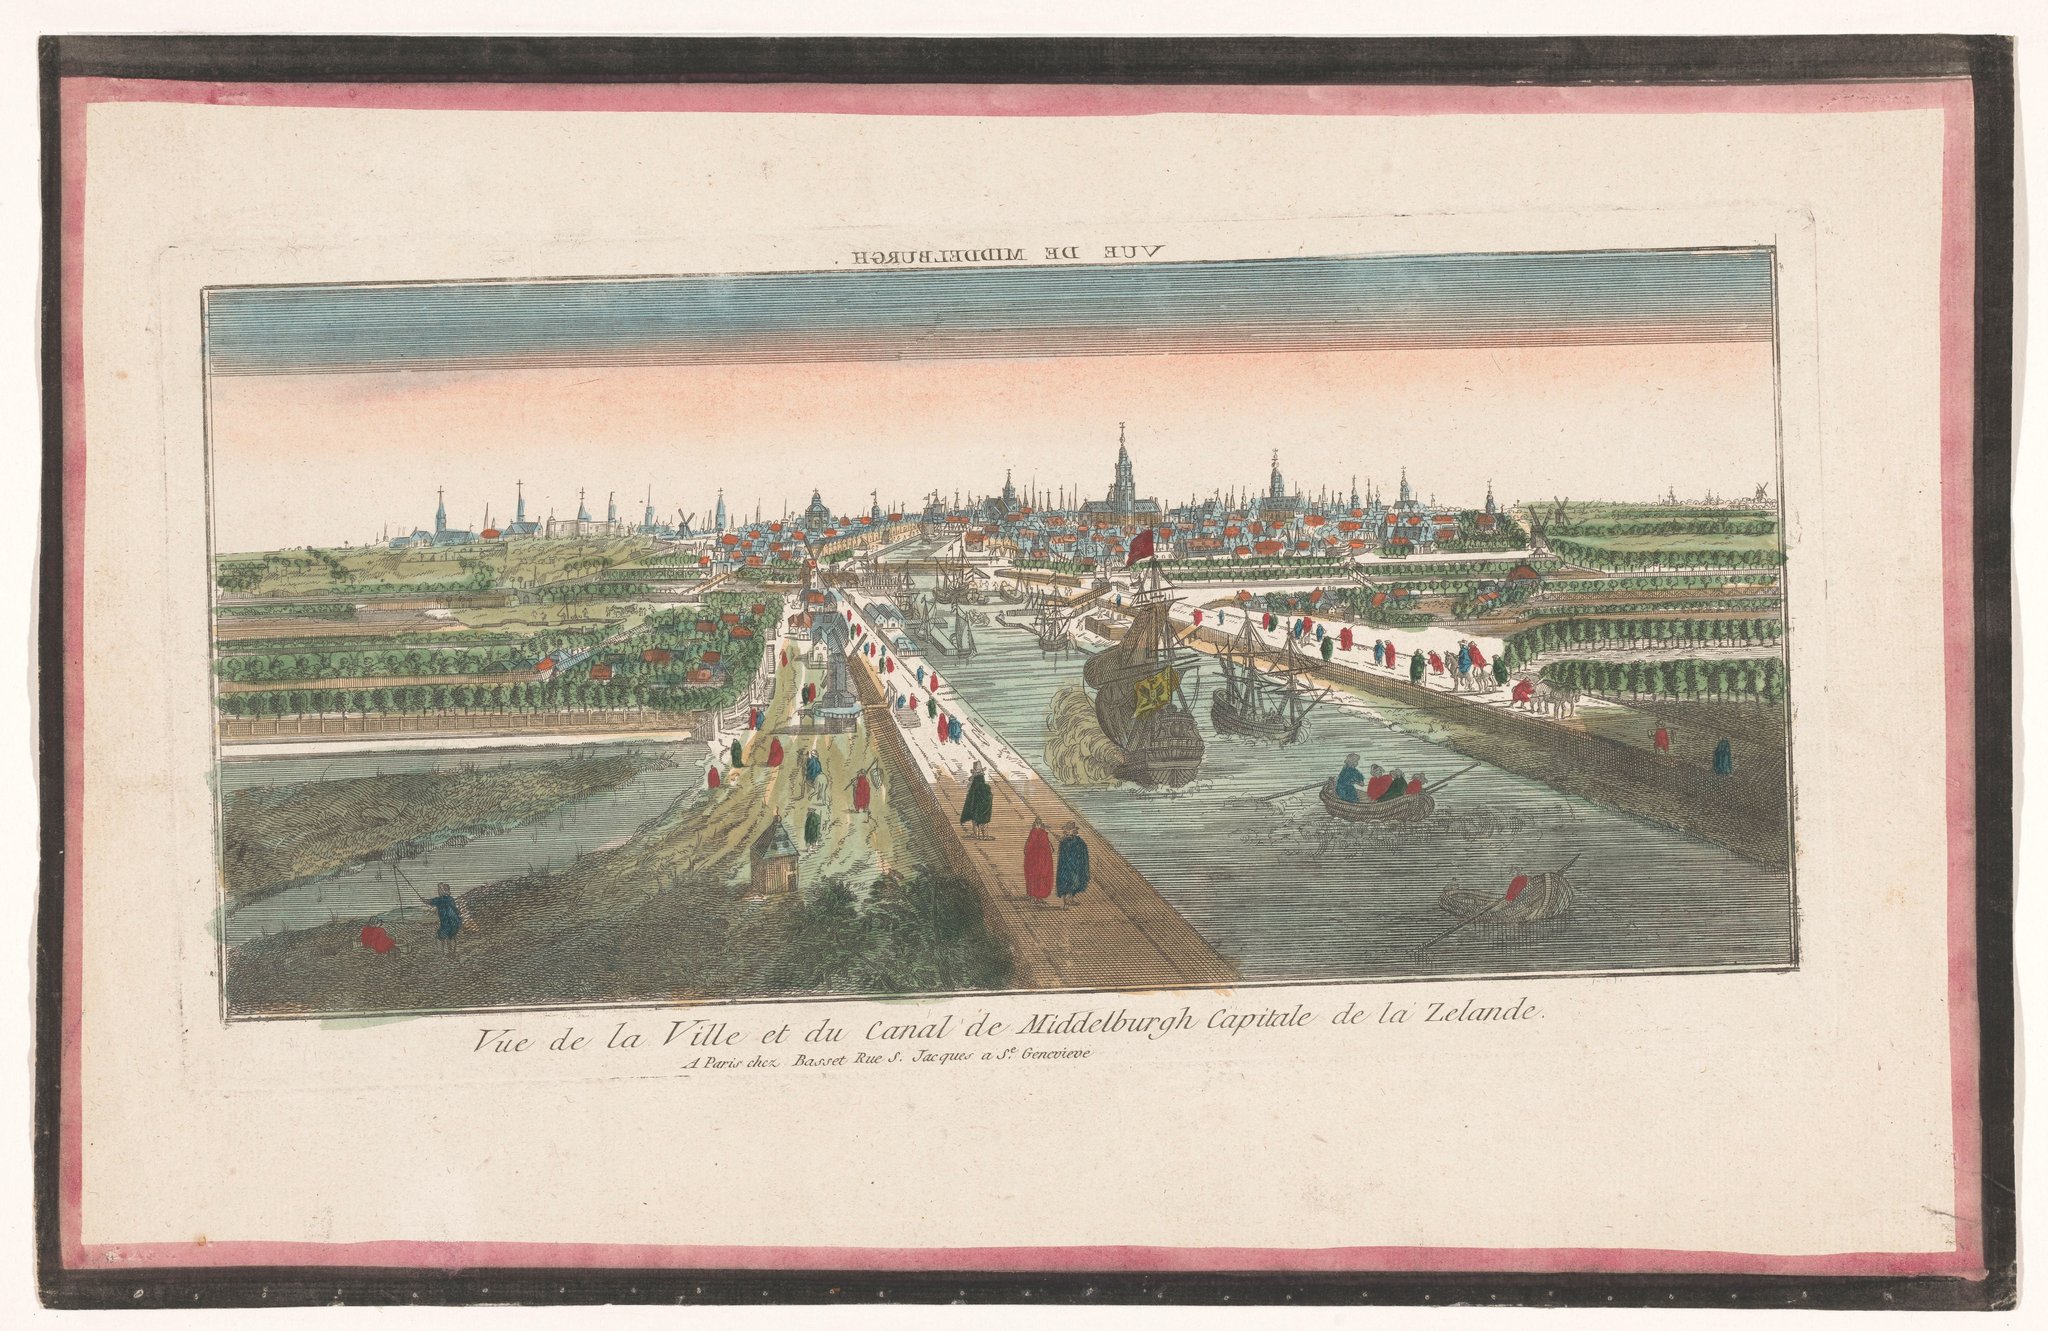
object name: opticaprent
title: Gezicht op de stad Middelburg en het Havenkanaal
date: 1700-1799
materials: paper, watercolor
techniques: brush, etching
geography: france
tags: sailing-ship, sailing-boat, canal, rowing-boat, canoe, etc., city-view in general; 'veduta' (+ city(-scape) with figures, staffage), middelburg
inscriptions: watermark, collector's mark: Lugt 2166